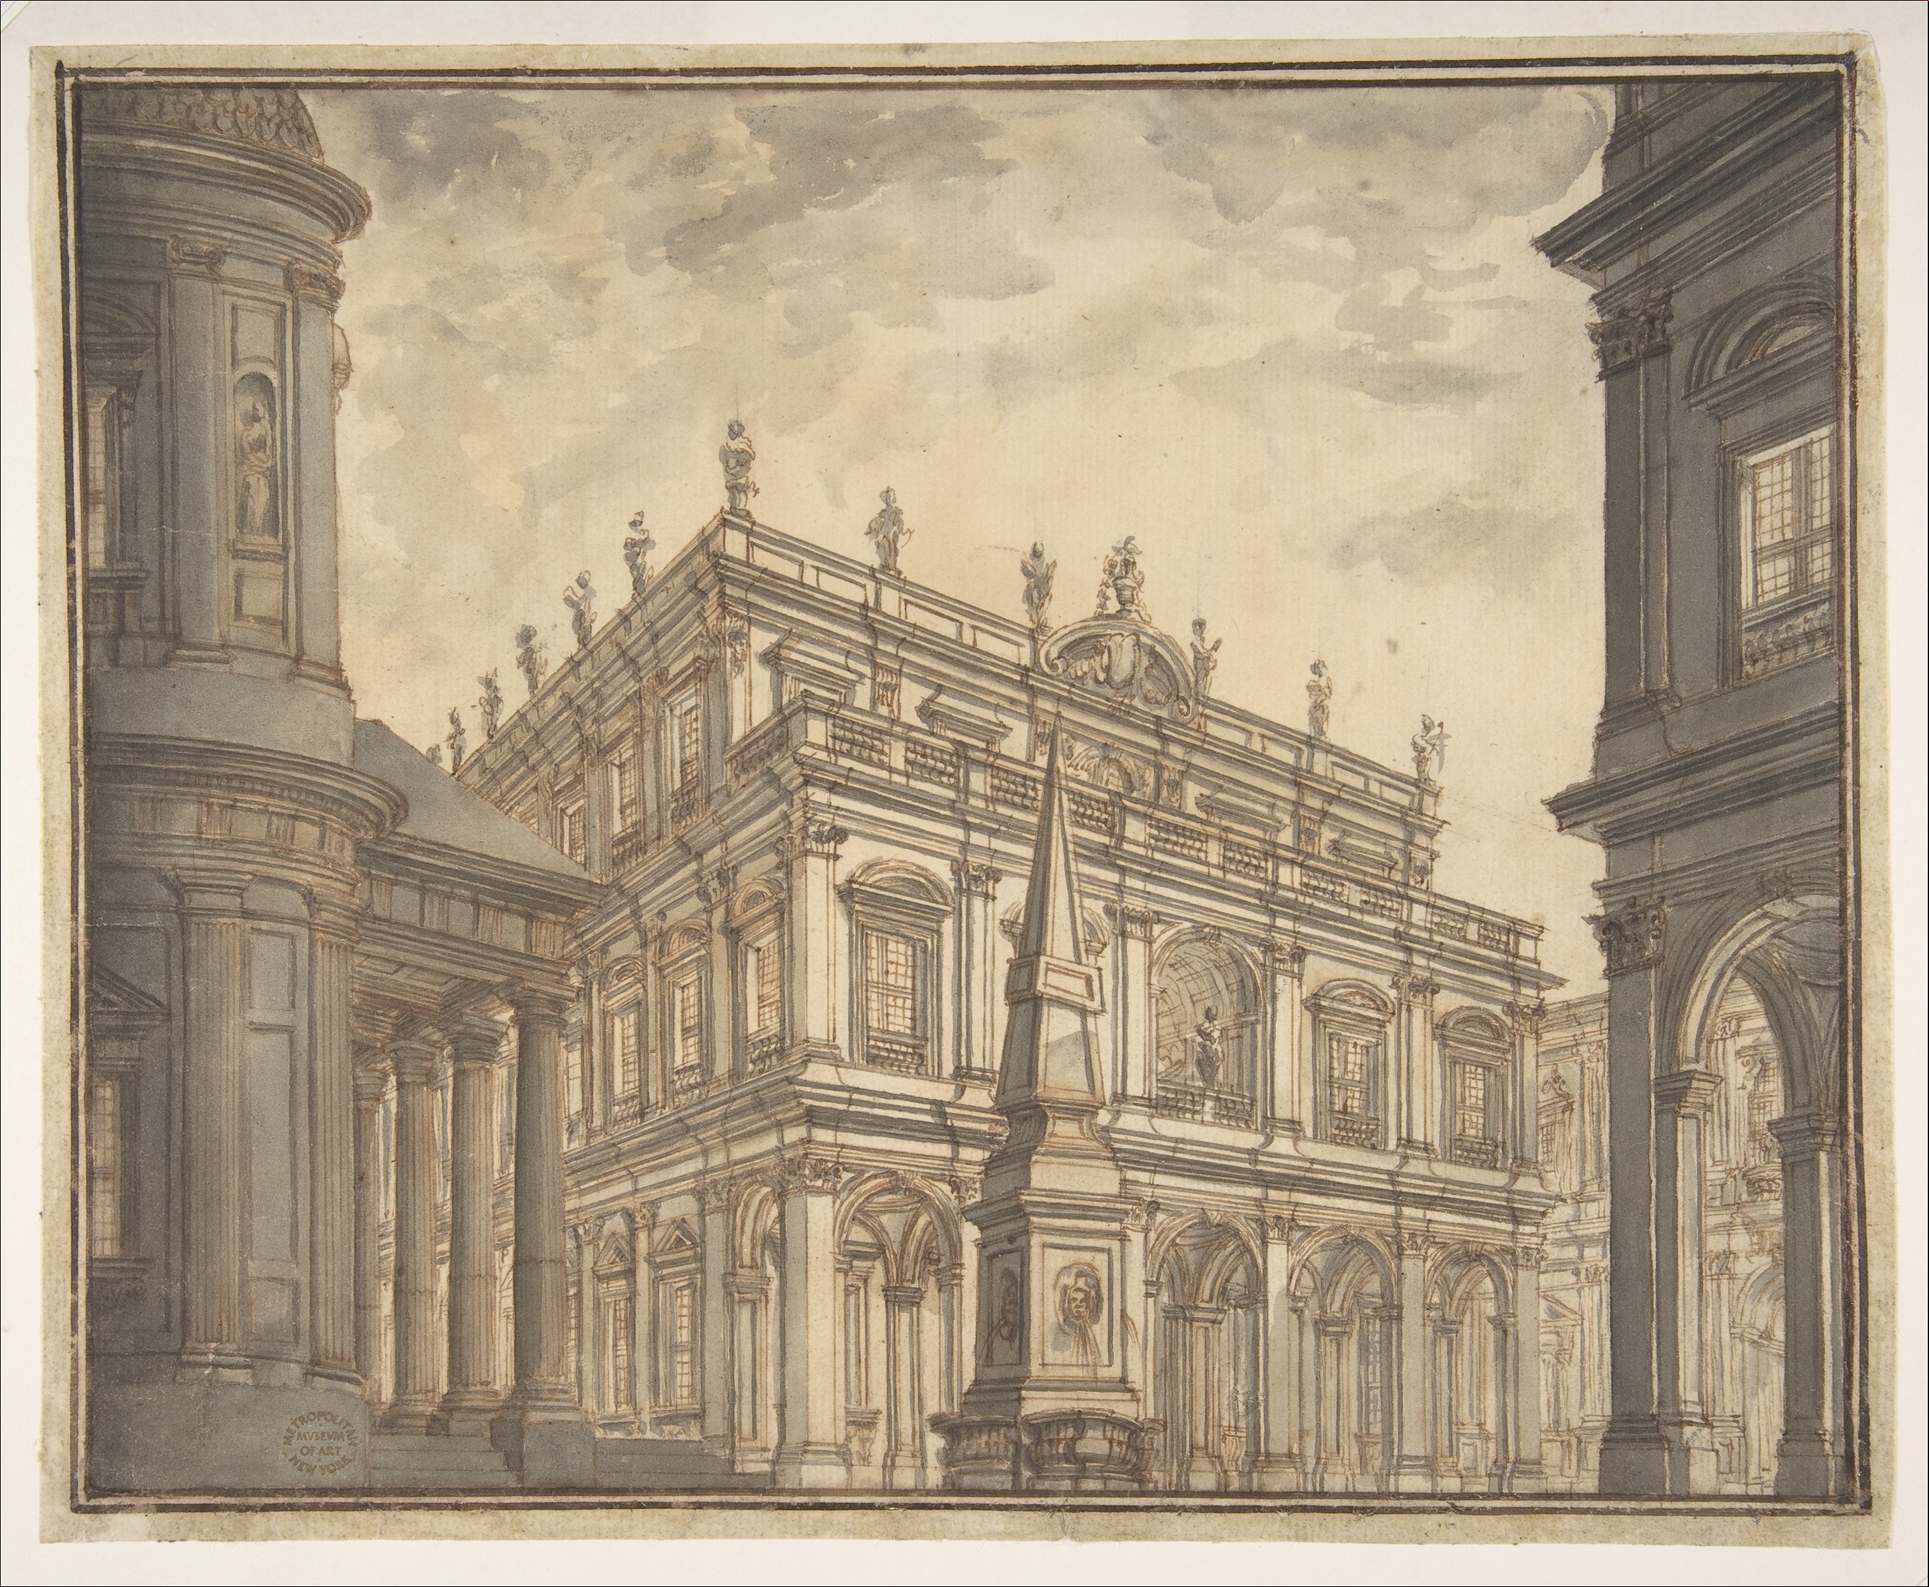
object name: drawing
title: Design for a Stage Set: A Town Square with a Fountain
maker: ferdinando galli bibiena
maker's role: artist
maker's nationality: italian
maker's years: 1657-1743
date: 1657-1743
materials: graphite, ink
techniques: brush, pen, wash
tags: buildings,fountains,stage design